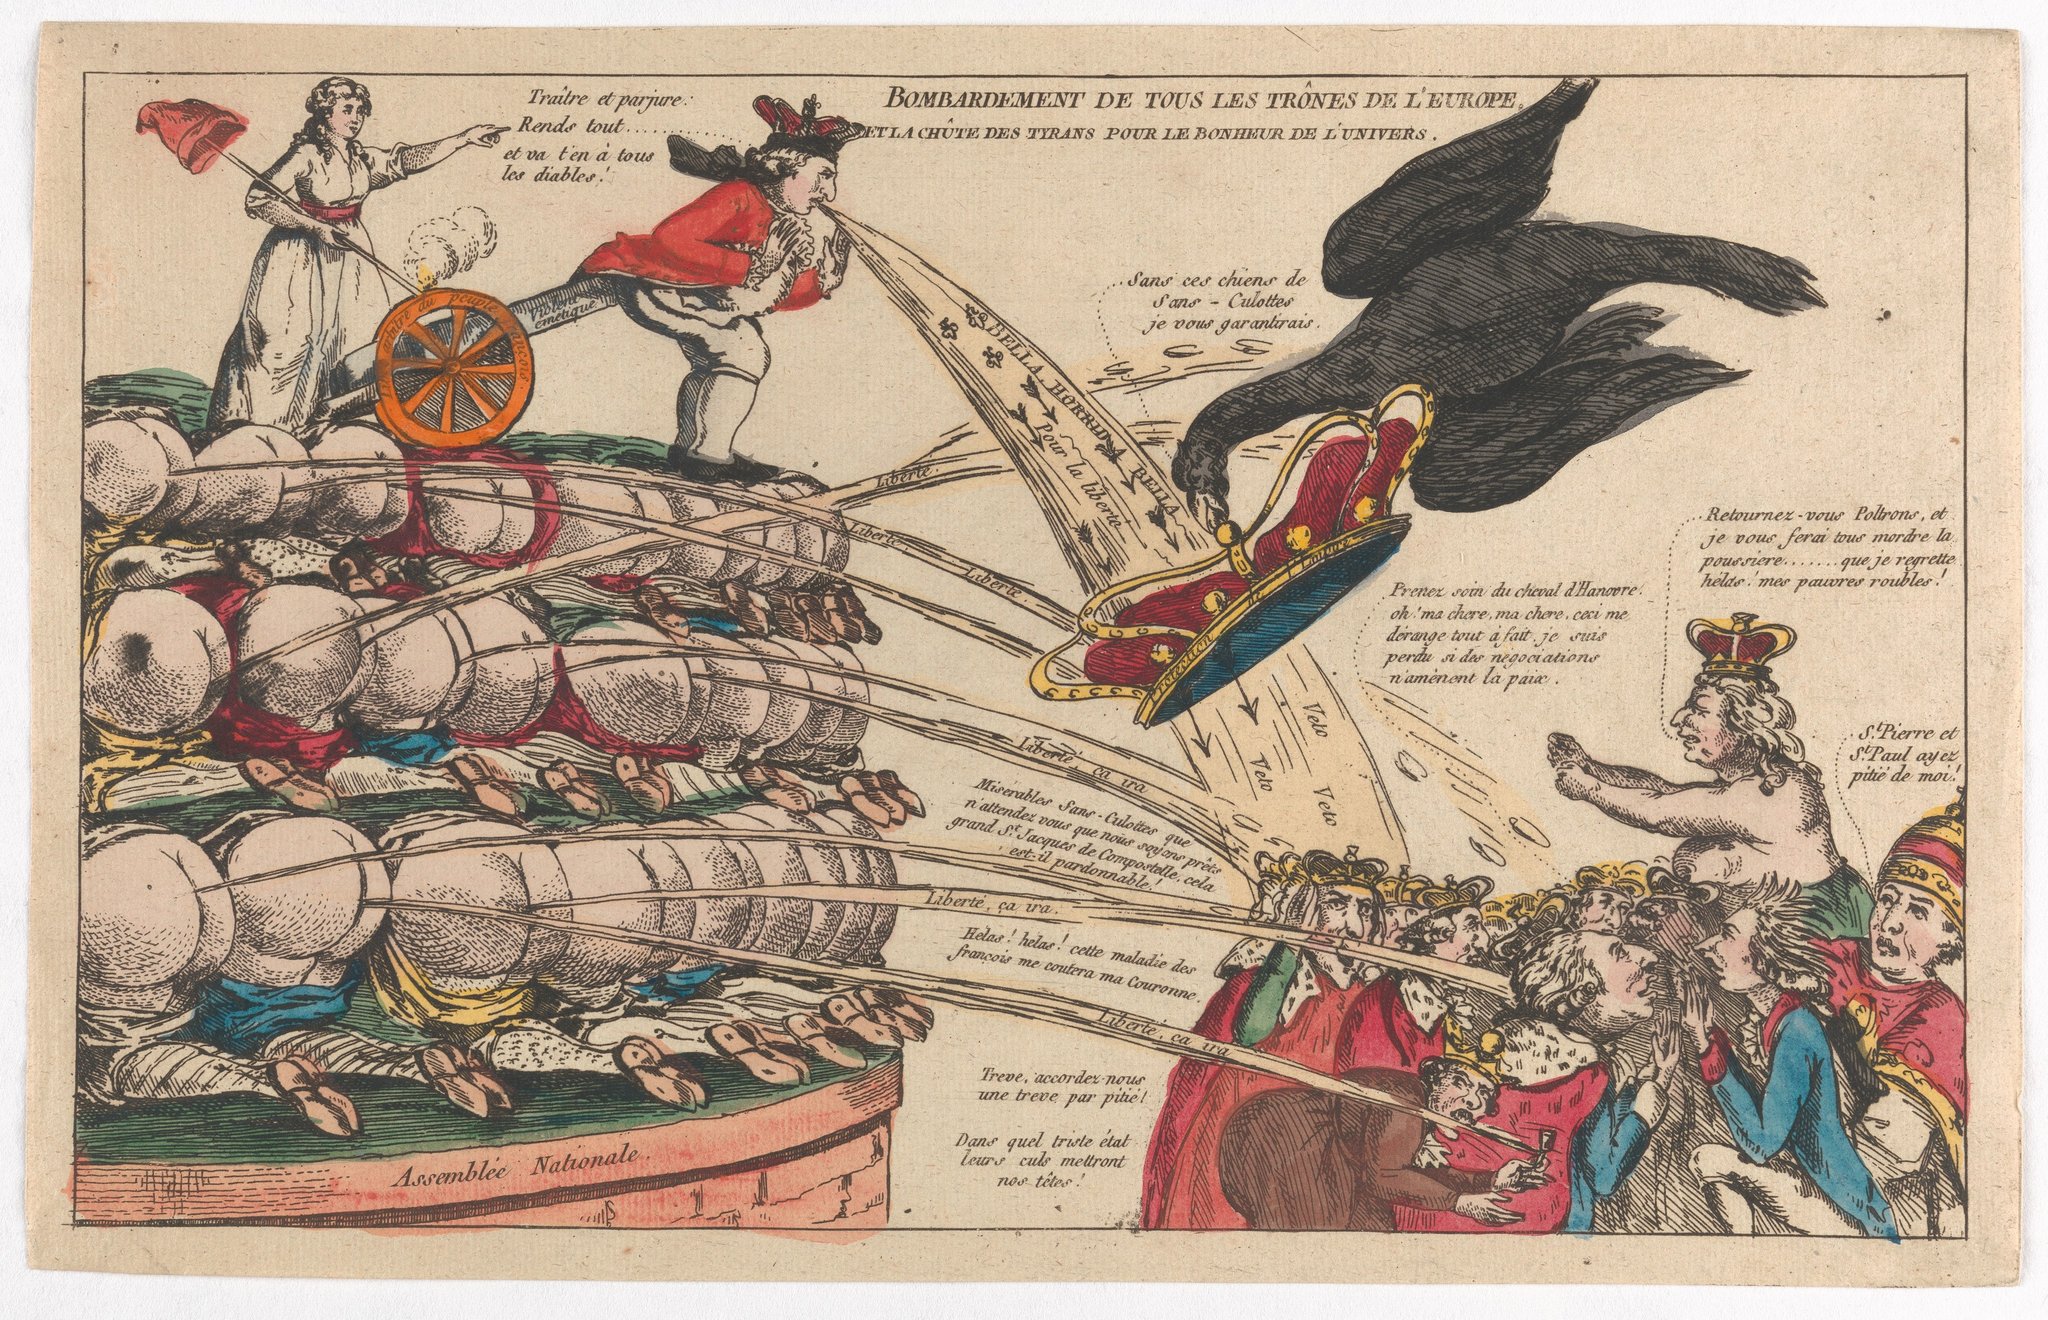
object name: print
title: The Bombardment of All the Thrones of Europe and the Fall of the Tyrants for the Happiness of the Universe (Bombardement de Tous les Trônes de l'Europe et la Chûte des Tyrans pour la Bonheur de l'Univers)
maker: anonymous, french, 18th century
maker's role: artist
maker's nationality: french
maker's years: 1700-1800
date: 1792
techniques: etching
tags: birds,satire,men,women,politics